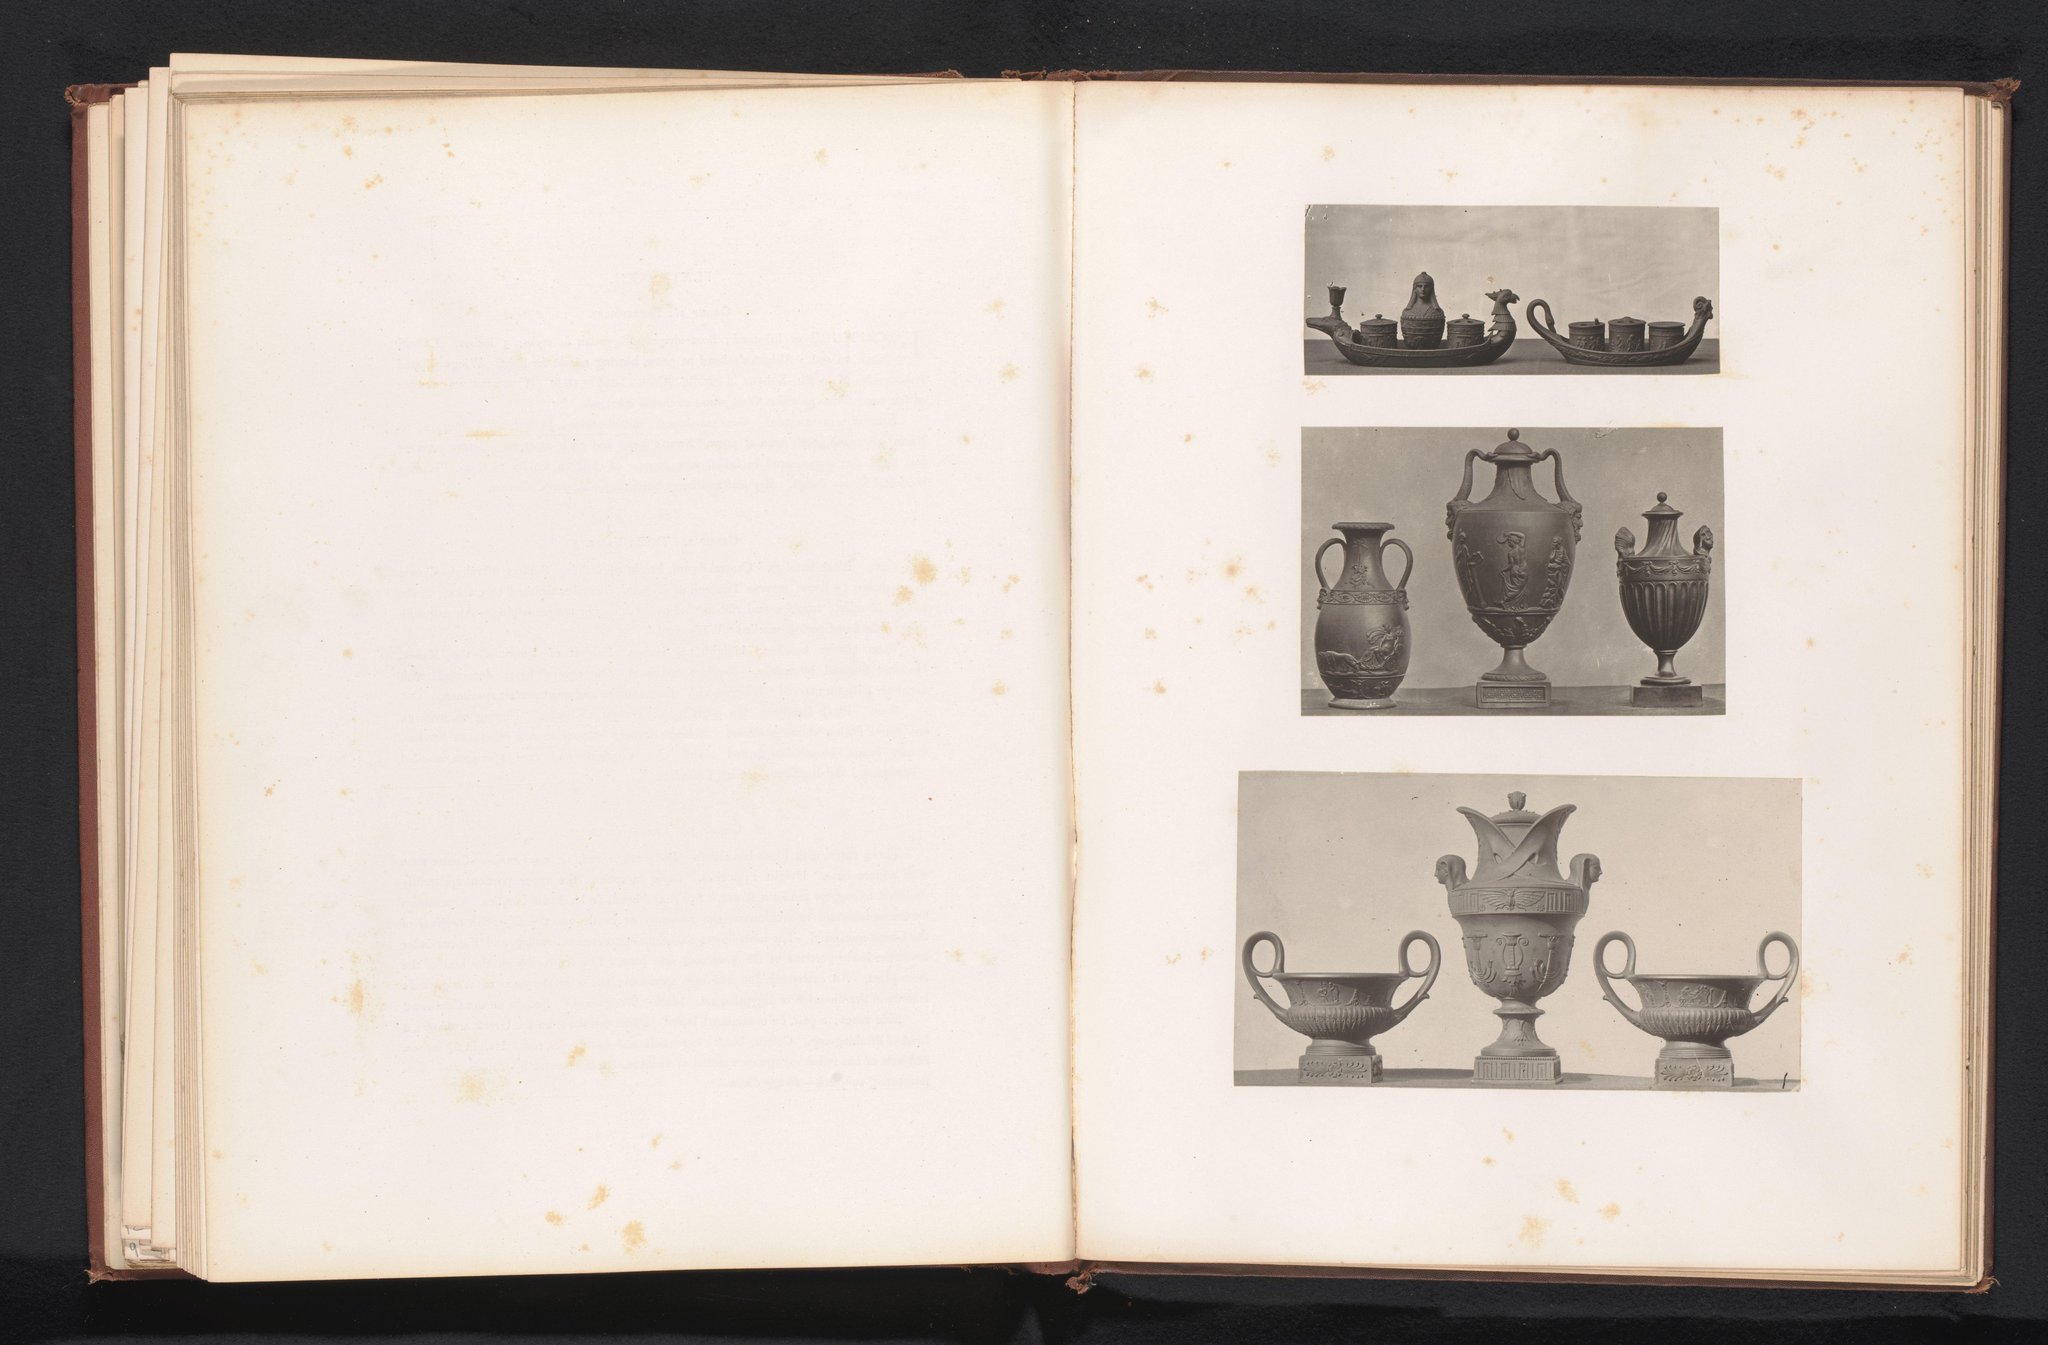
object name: page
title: Twee inktpotten en zes vazen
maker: joseph cundall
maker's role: fotograaf, schrijver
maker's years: 1818-1895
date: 1868-1873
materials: paper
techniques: carbon print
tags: ink-well, container of ceramics: jar, jug, pot, vase, sculpture (+ relief ~ sculpture)